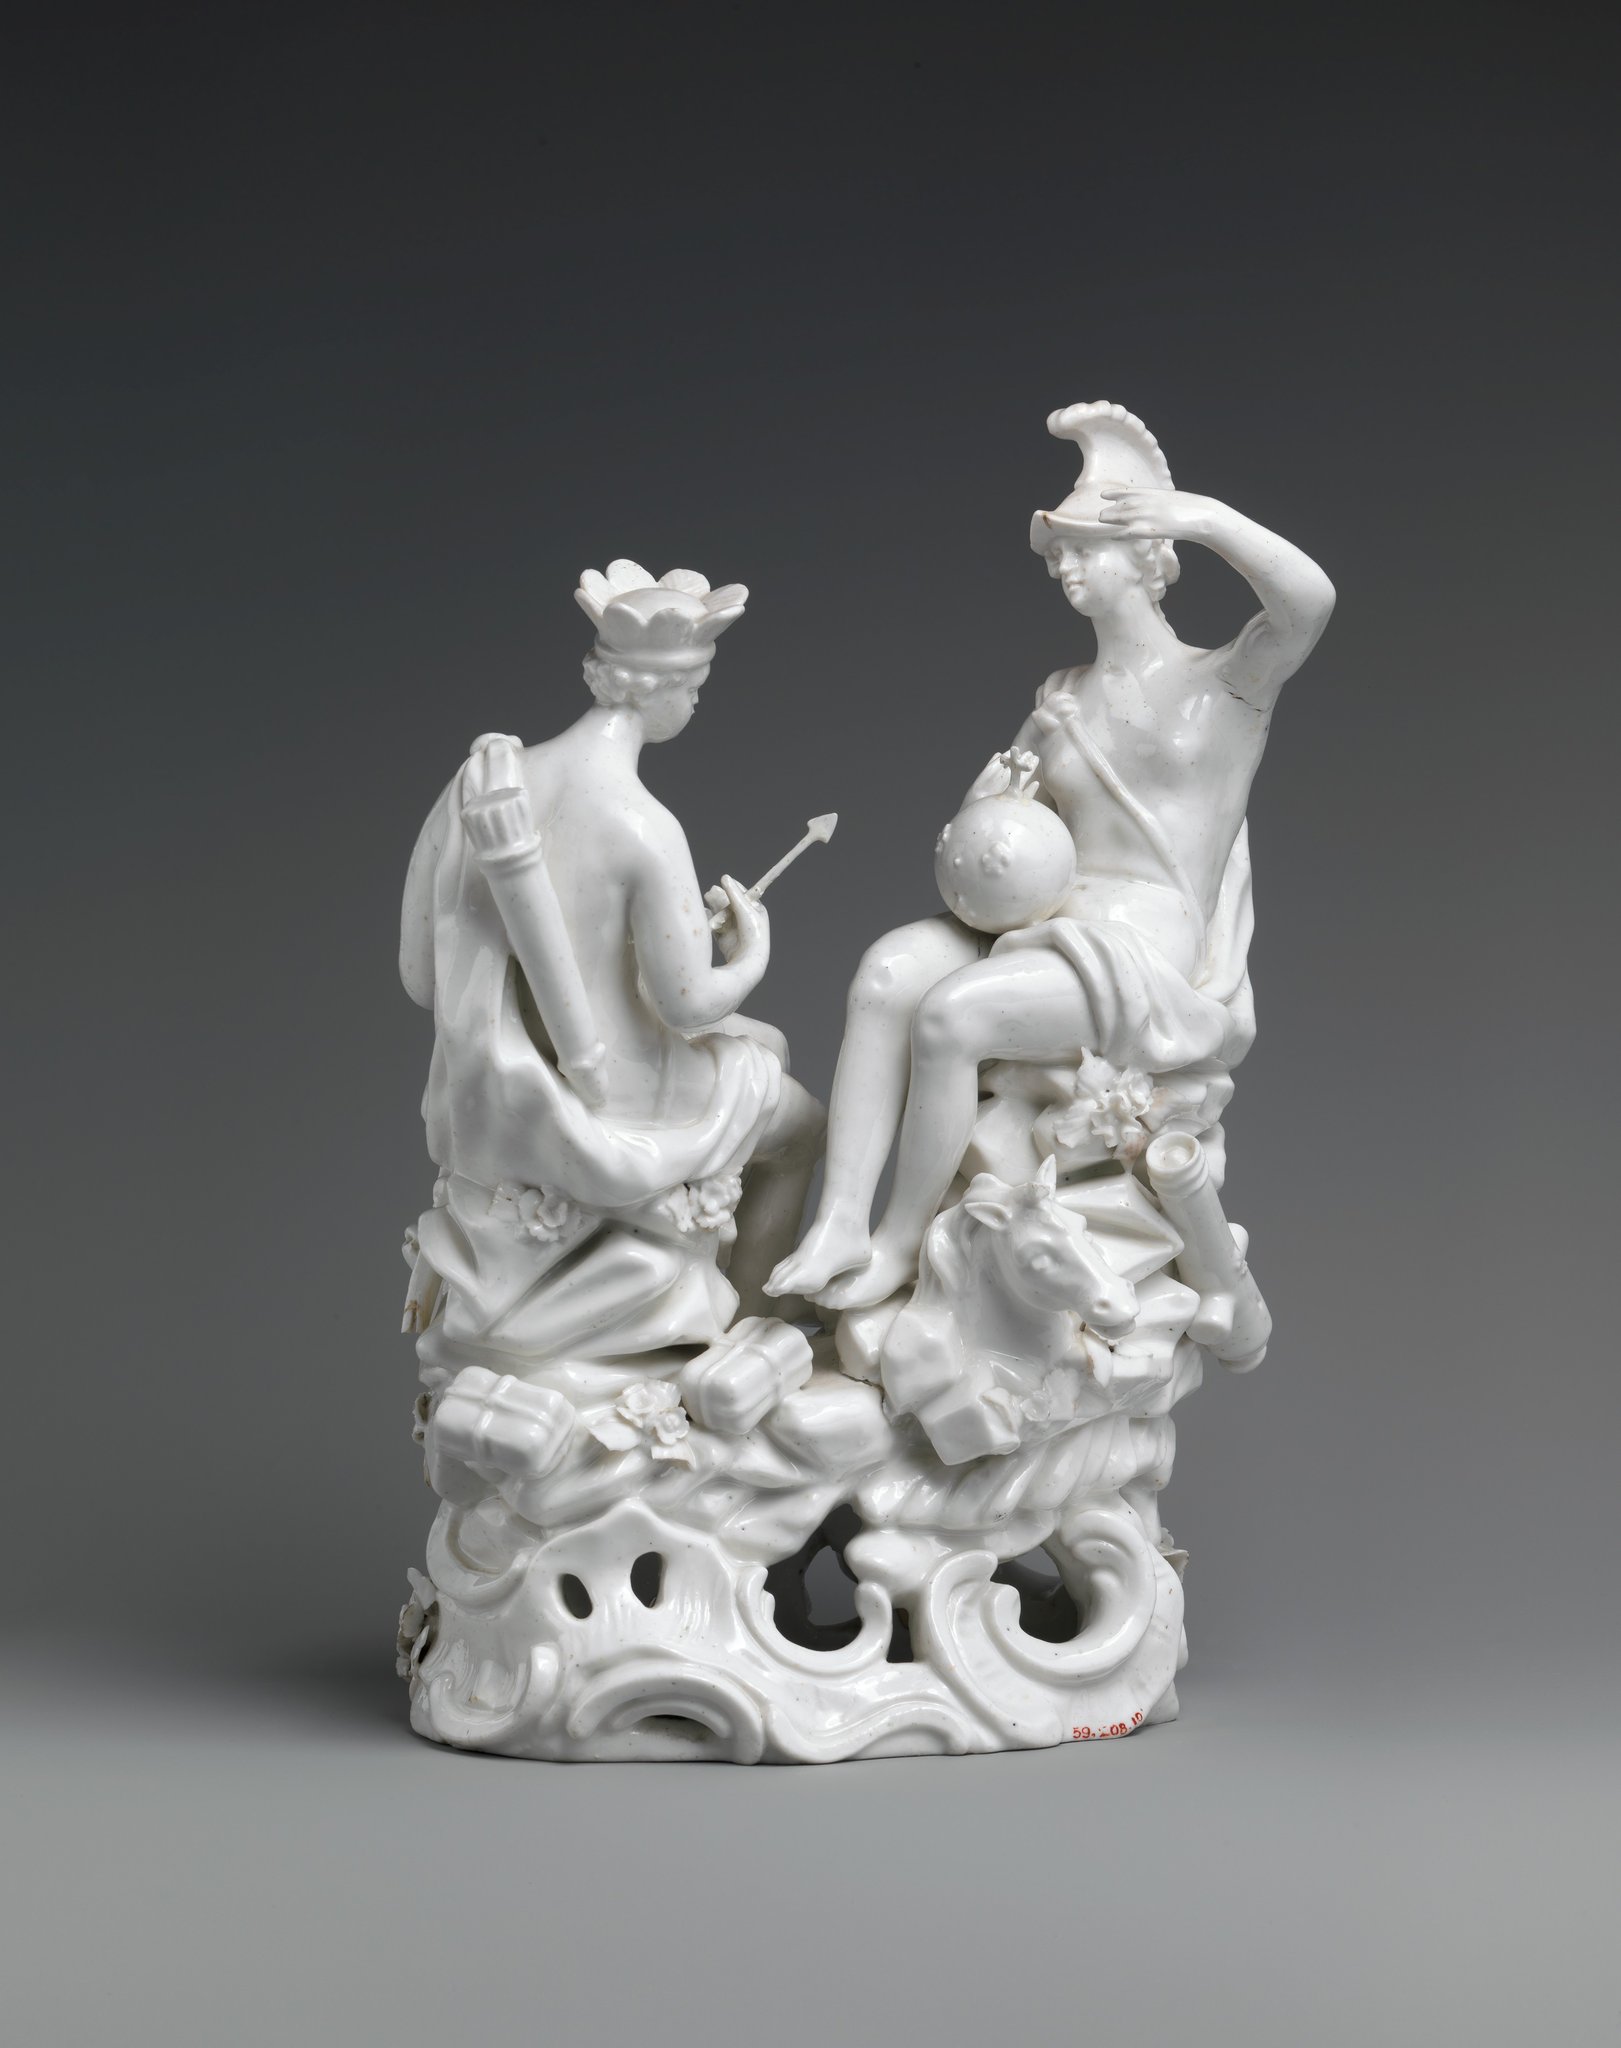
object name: group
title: Europe and America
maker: orléans manufactory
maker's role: manufactory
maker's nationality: french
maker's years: 1753-1782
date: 1760-1770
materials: soft paste porcelain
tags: bow and arrow,men,horses